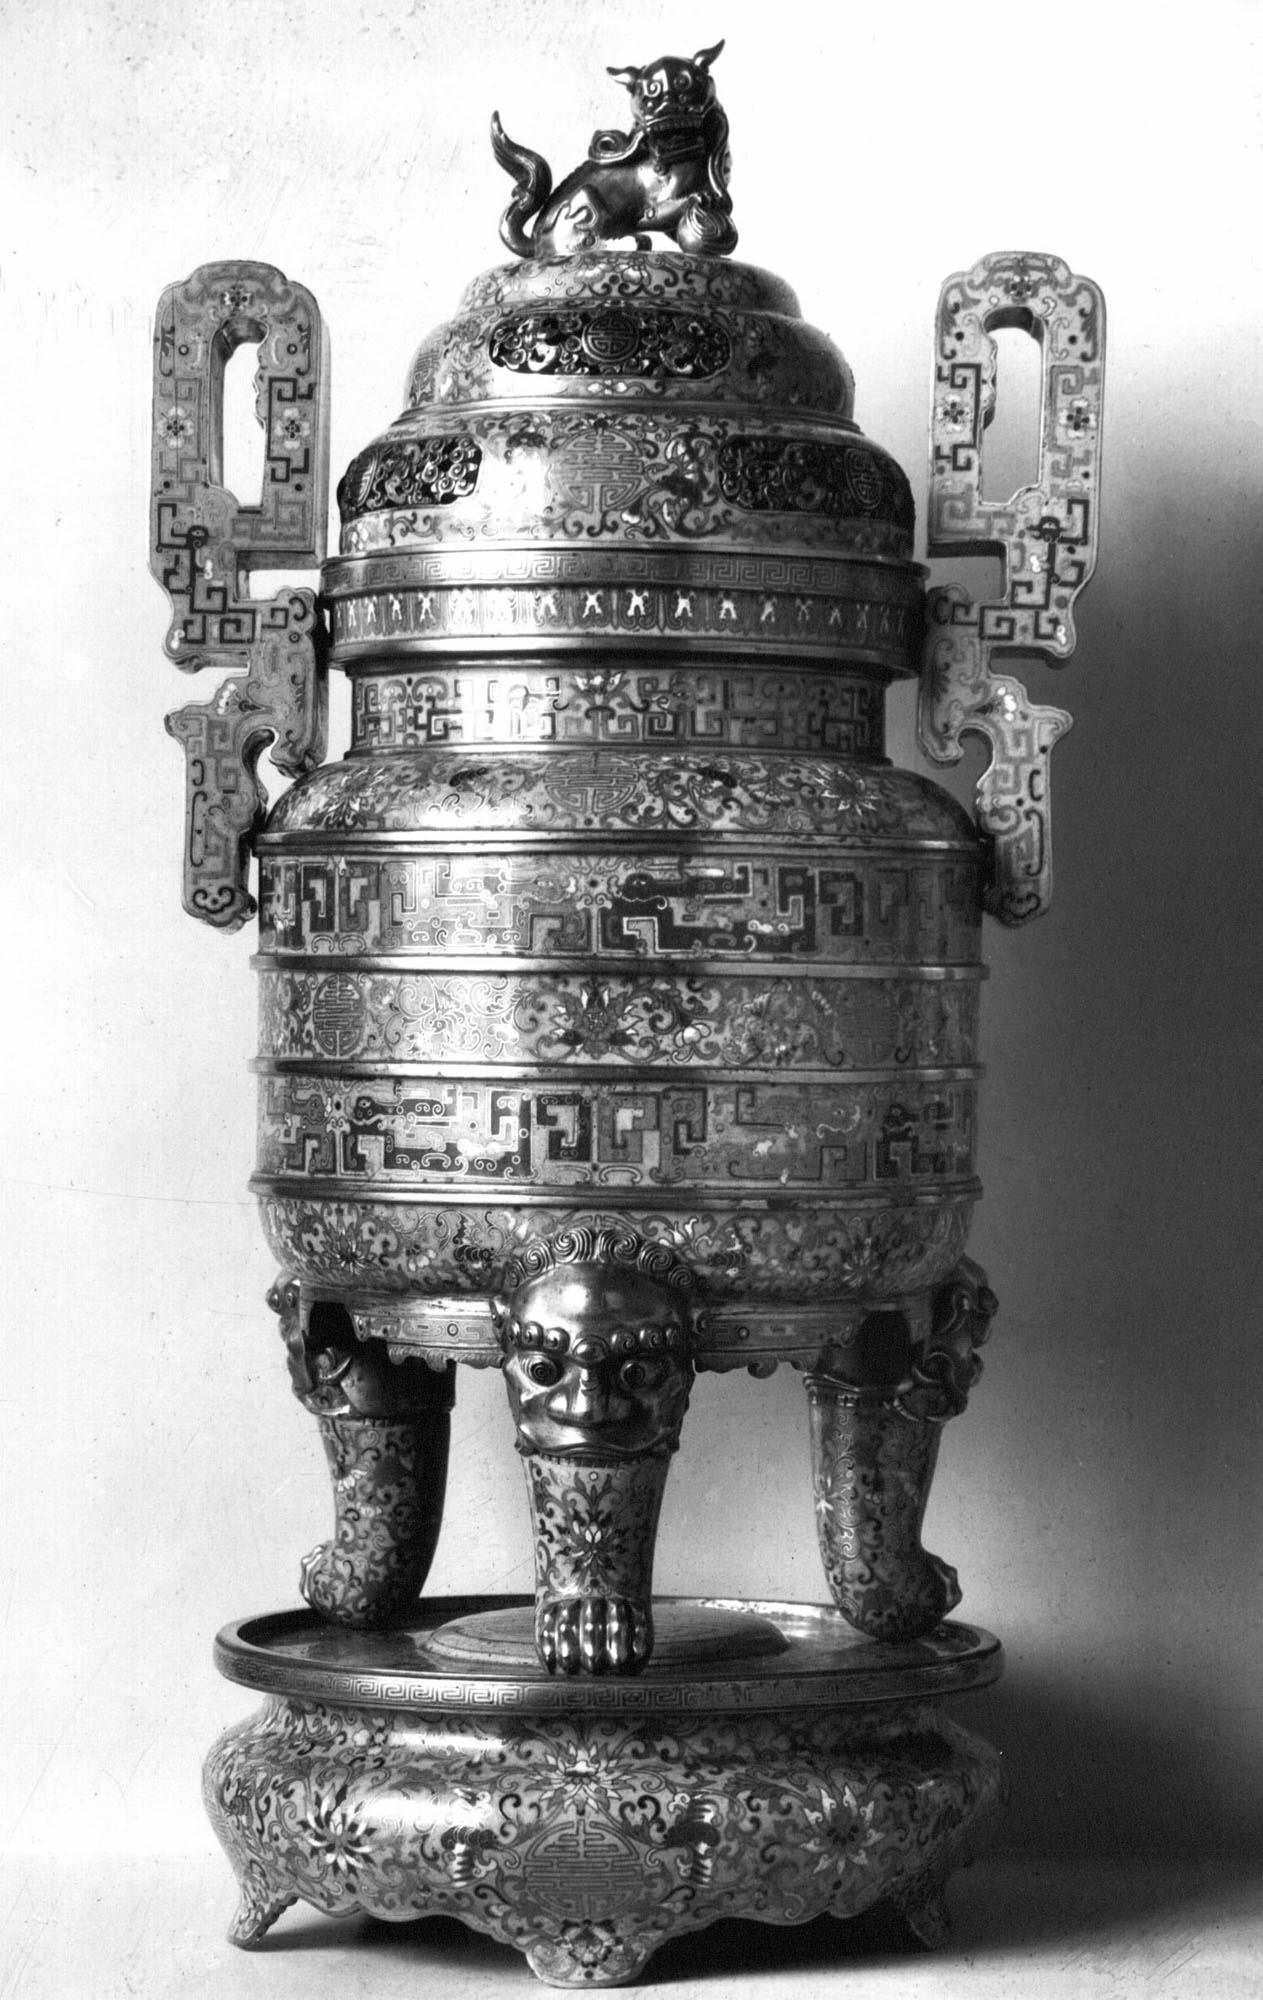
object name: incense burner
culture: chinese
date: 1736-1795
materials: enamel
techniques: enamel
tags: animals